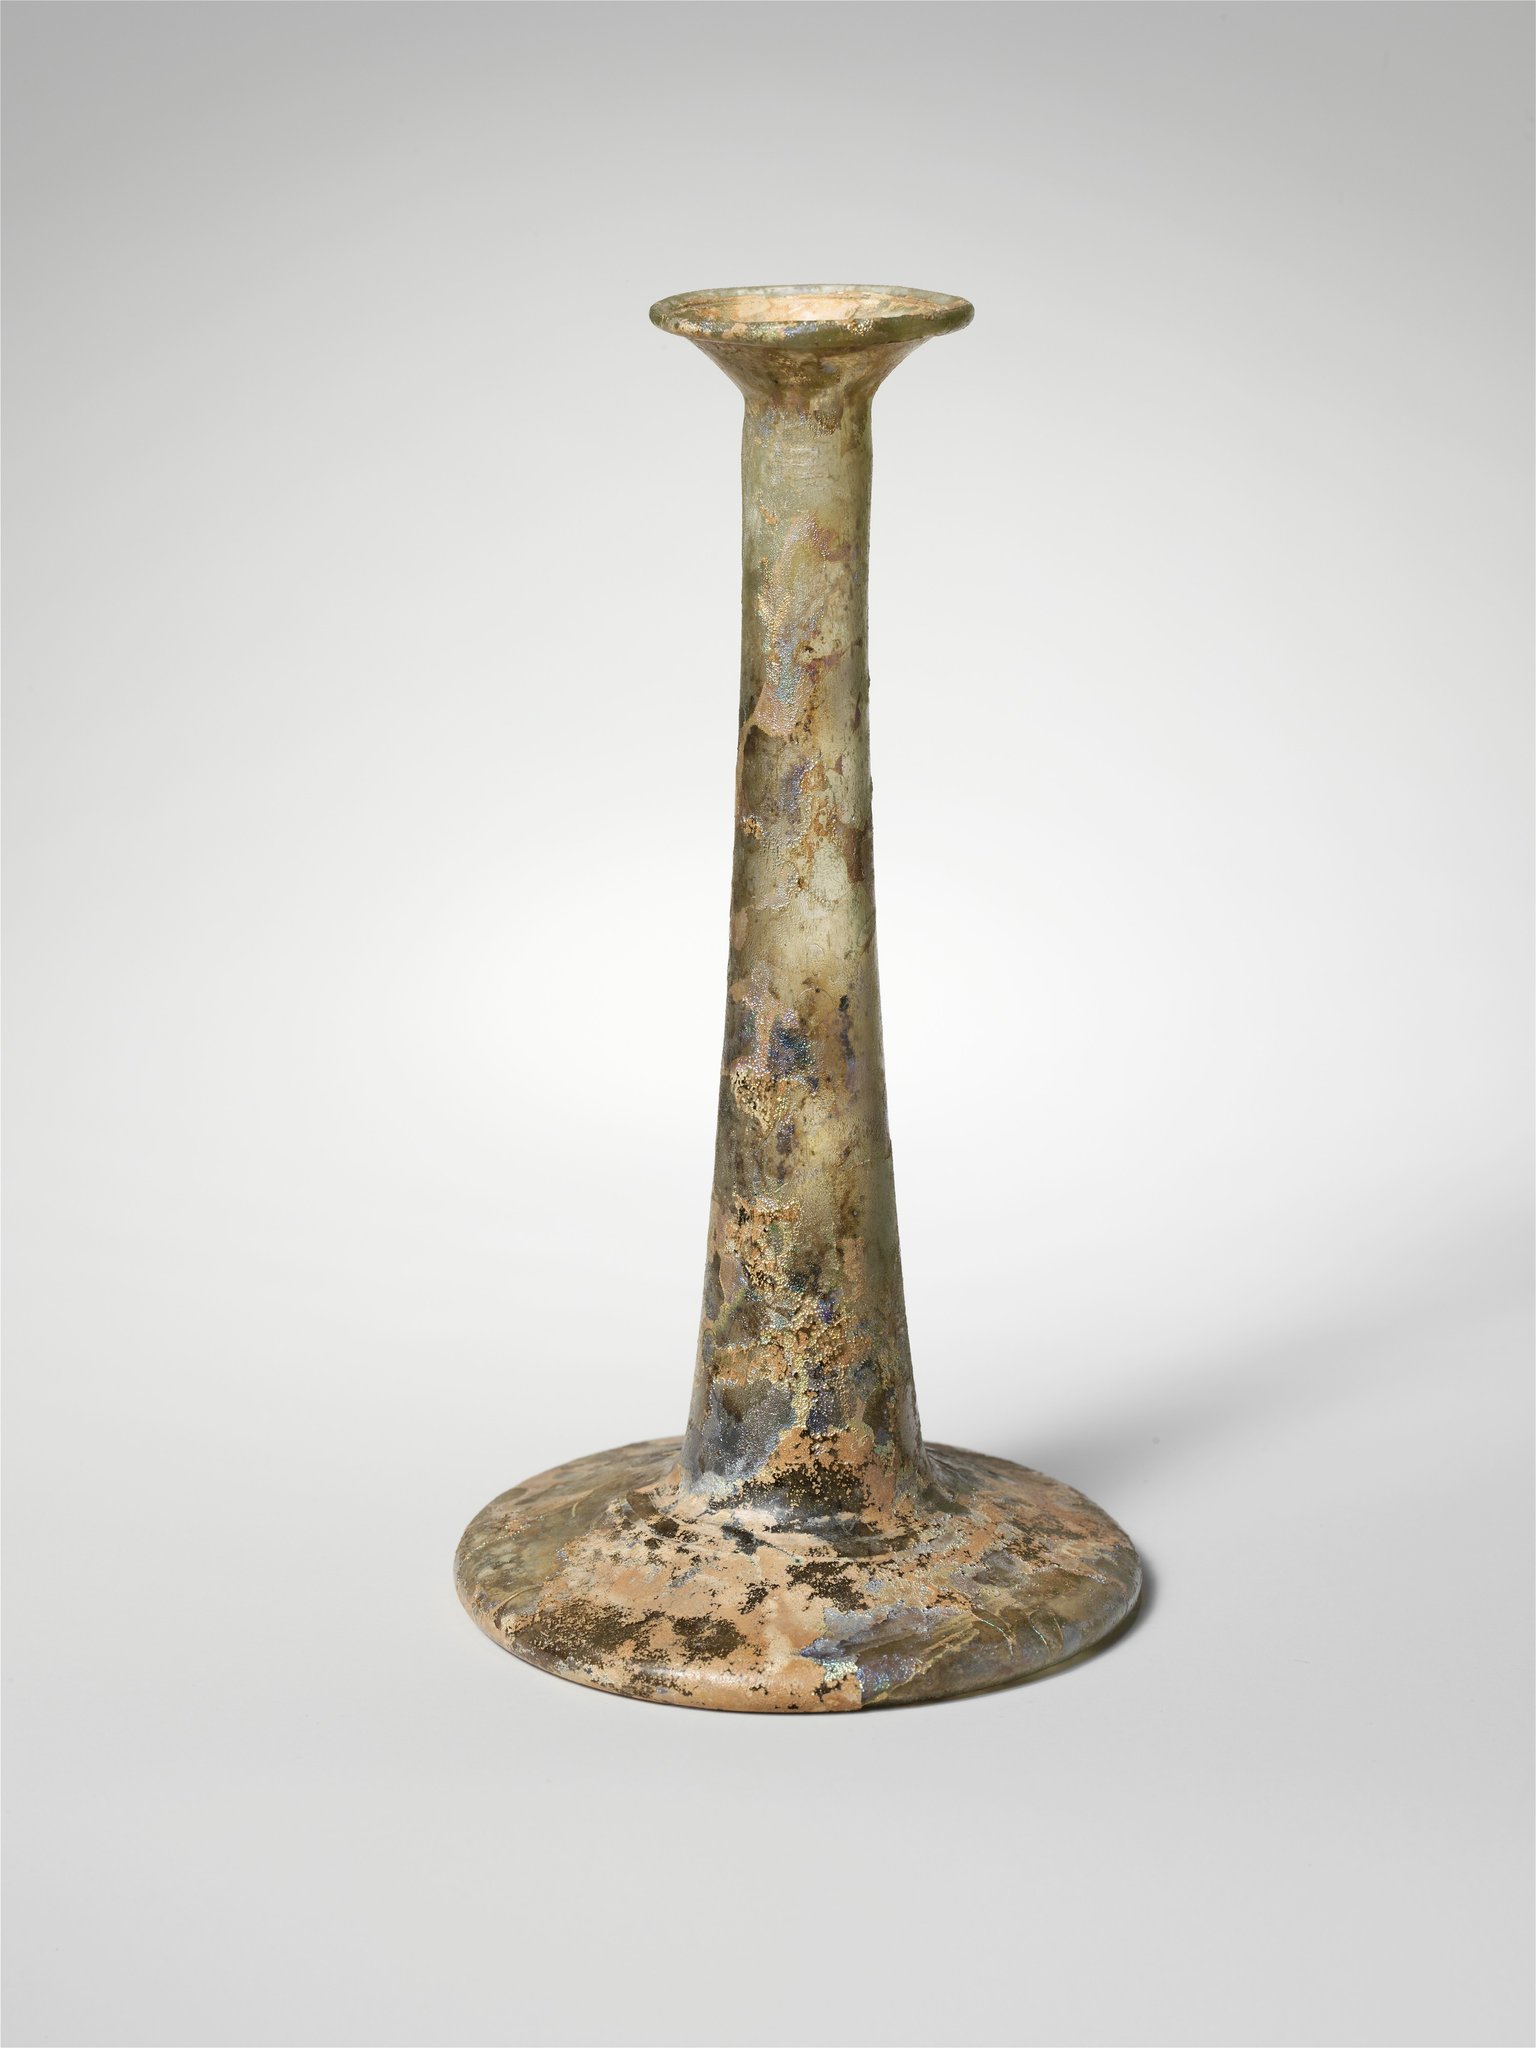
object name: candlestick perfume bottle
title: Glass perfume bottle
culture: roman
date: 101-300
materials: glass